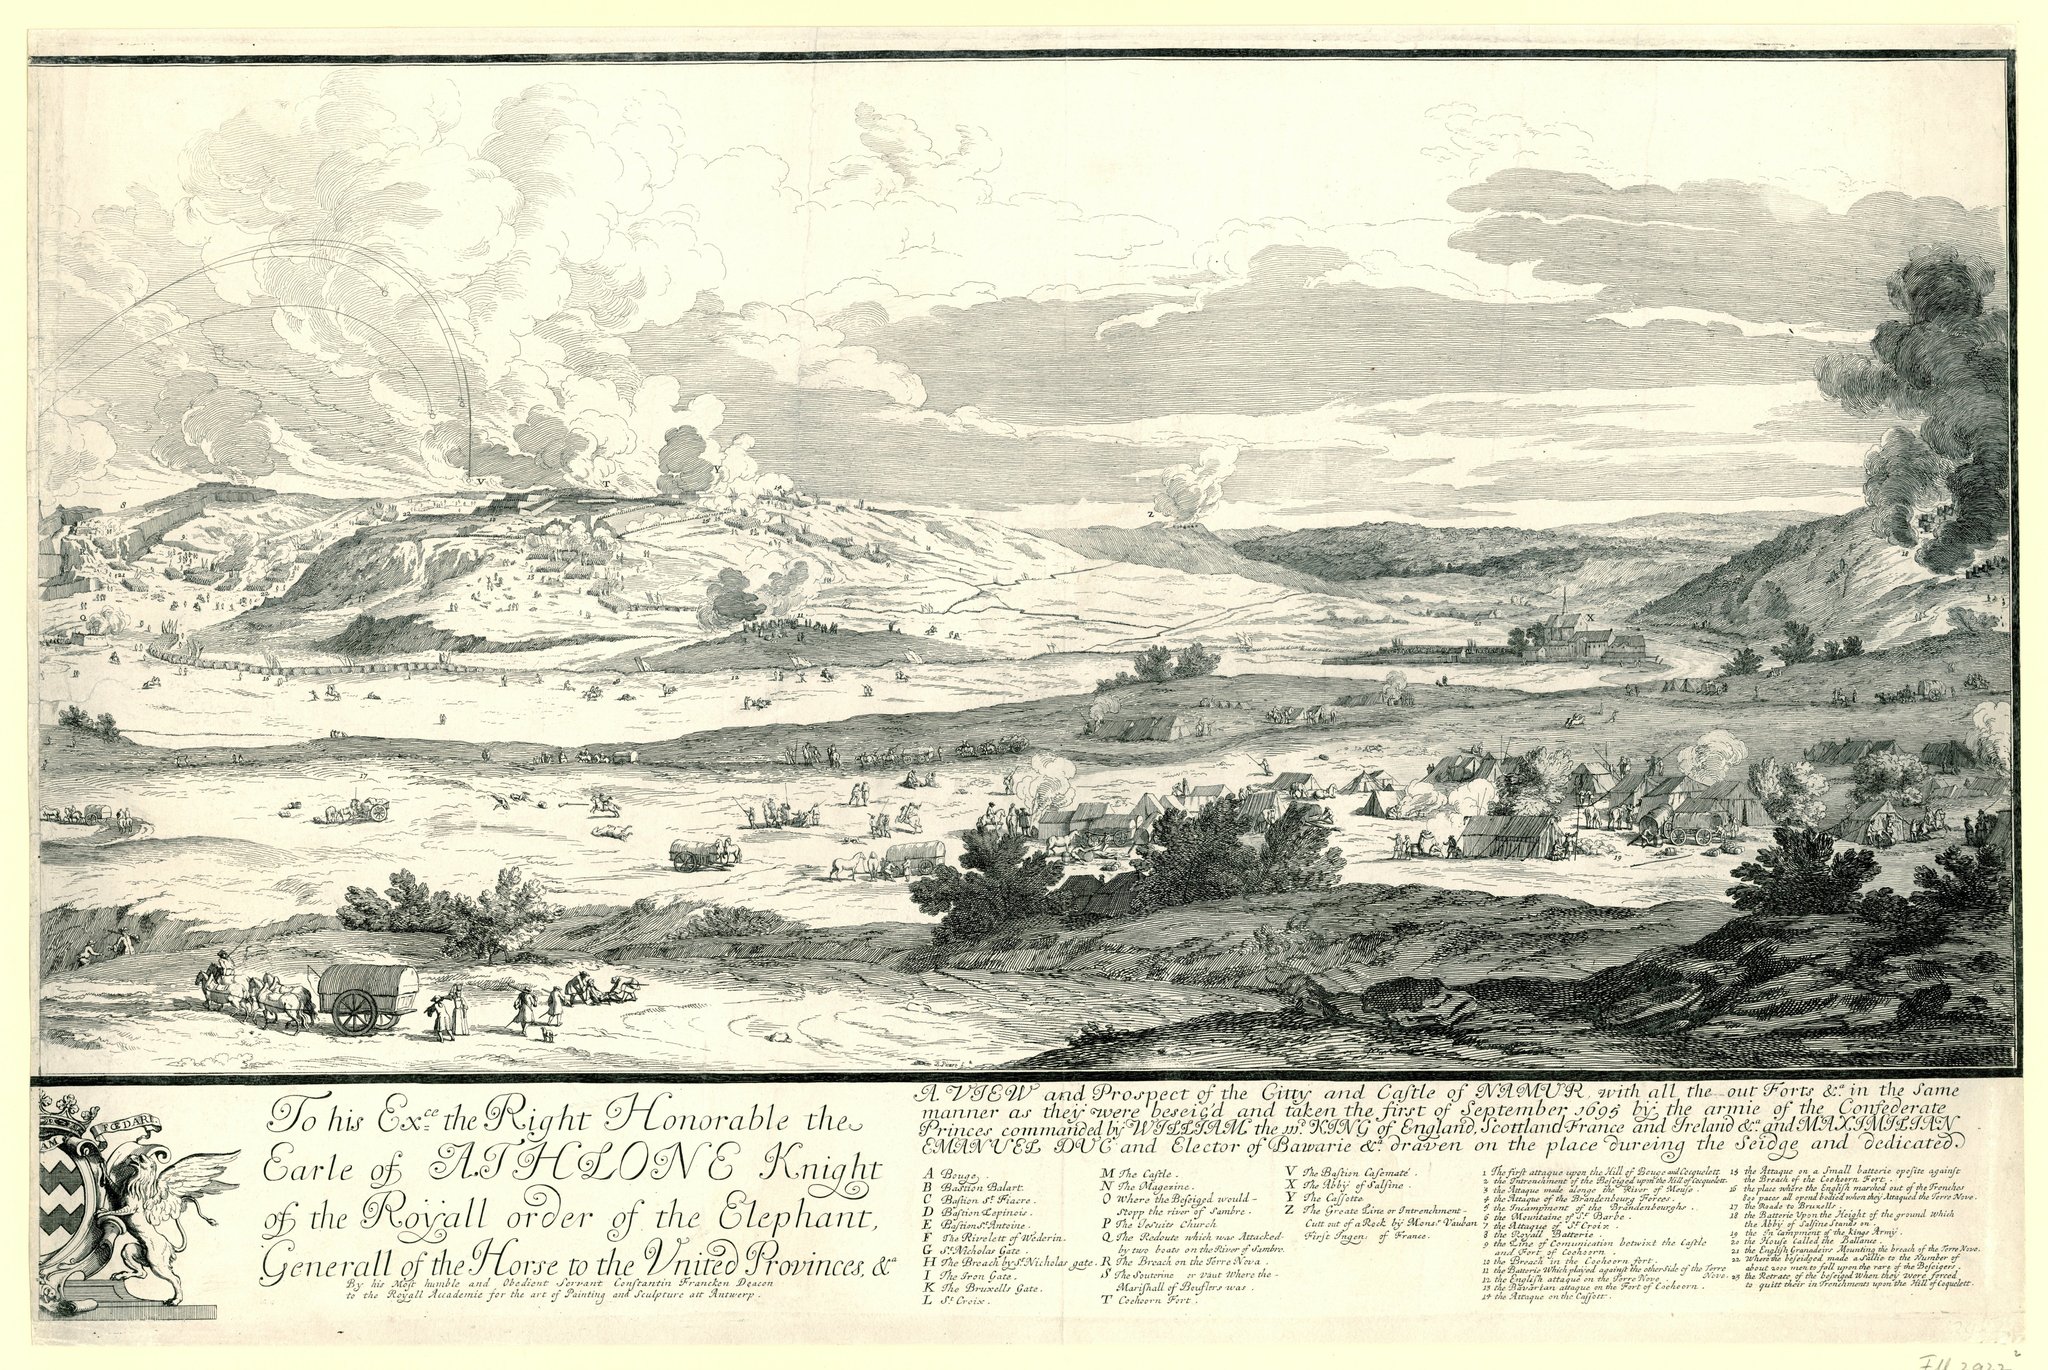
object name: print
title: Gezicht op het beleg van Namen (rechterhelft), 1695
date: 1697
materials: paper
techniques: etching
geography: northern netherlands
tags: the hague, william iii (prince of orange and king of england, scotland, and ireland), maximiliaan ii emanuel (keurvorst van beieren), siege, position war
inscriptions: date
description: Rechterhelft van een grote voorstelling in twee delen van het beleg van Namen in 1695 door de Geallieerden onder koning Willem III en de keurvorst van Beieren. Op de voorgrond rechts een deel van het legerkamp van de Geallieerdentent. In het onderschrift de opdracht en de legenda A-Z en 1-23 in het Engels. Zie voor het rechterdeel met Engelse titel de prent met objectnummer RP-P-OB-77.338A.